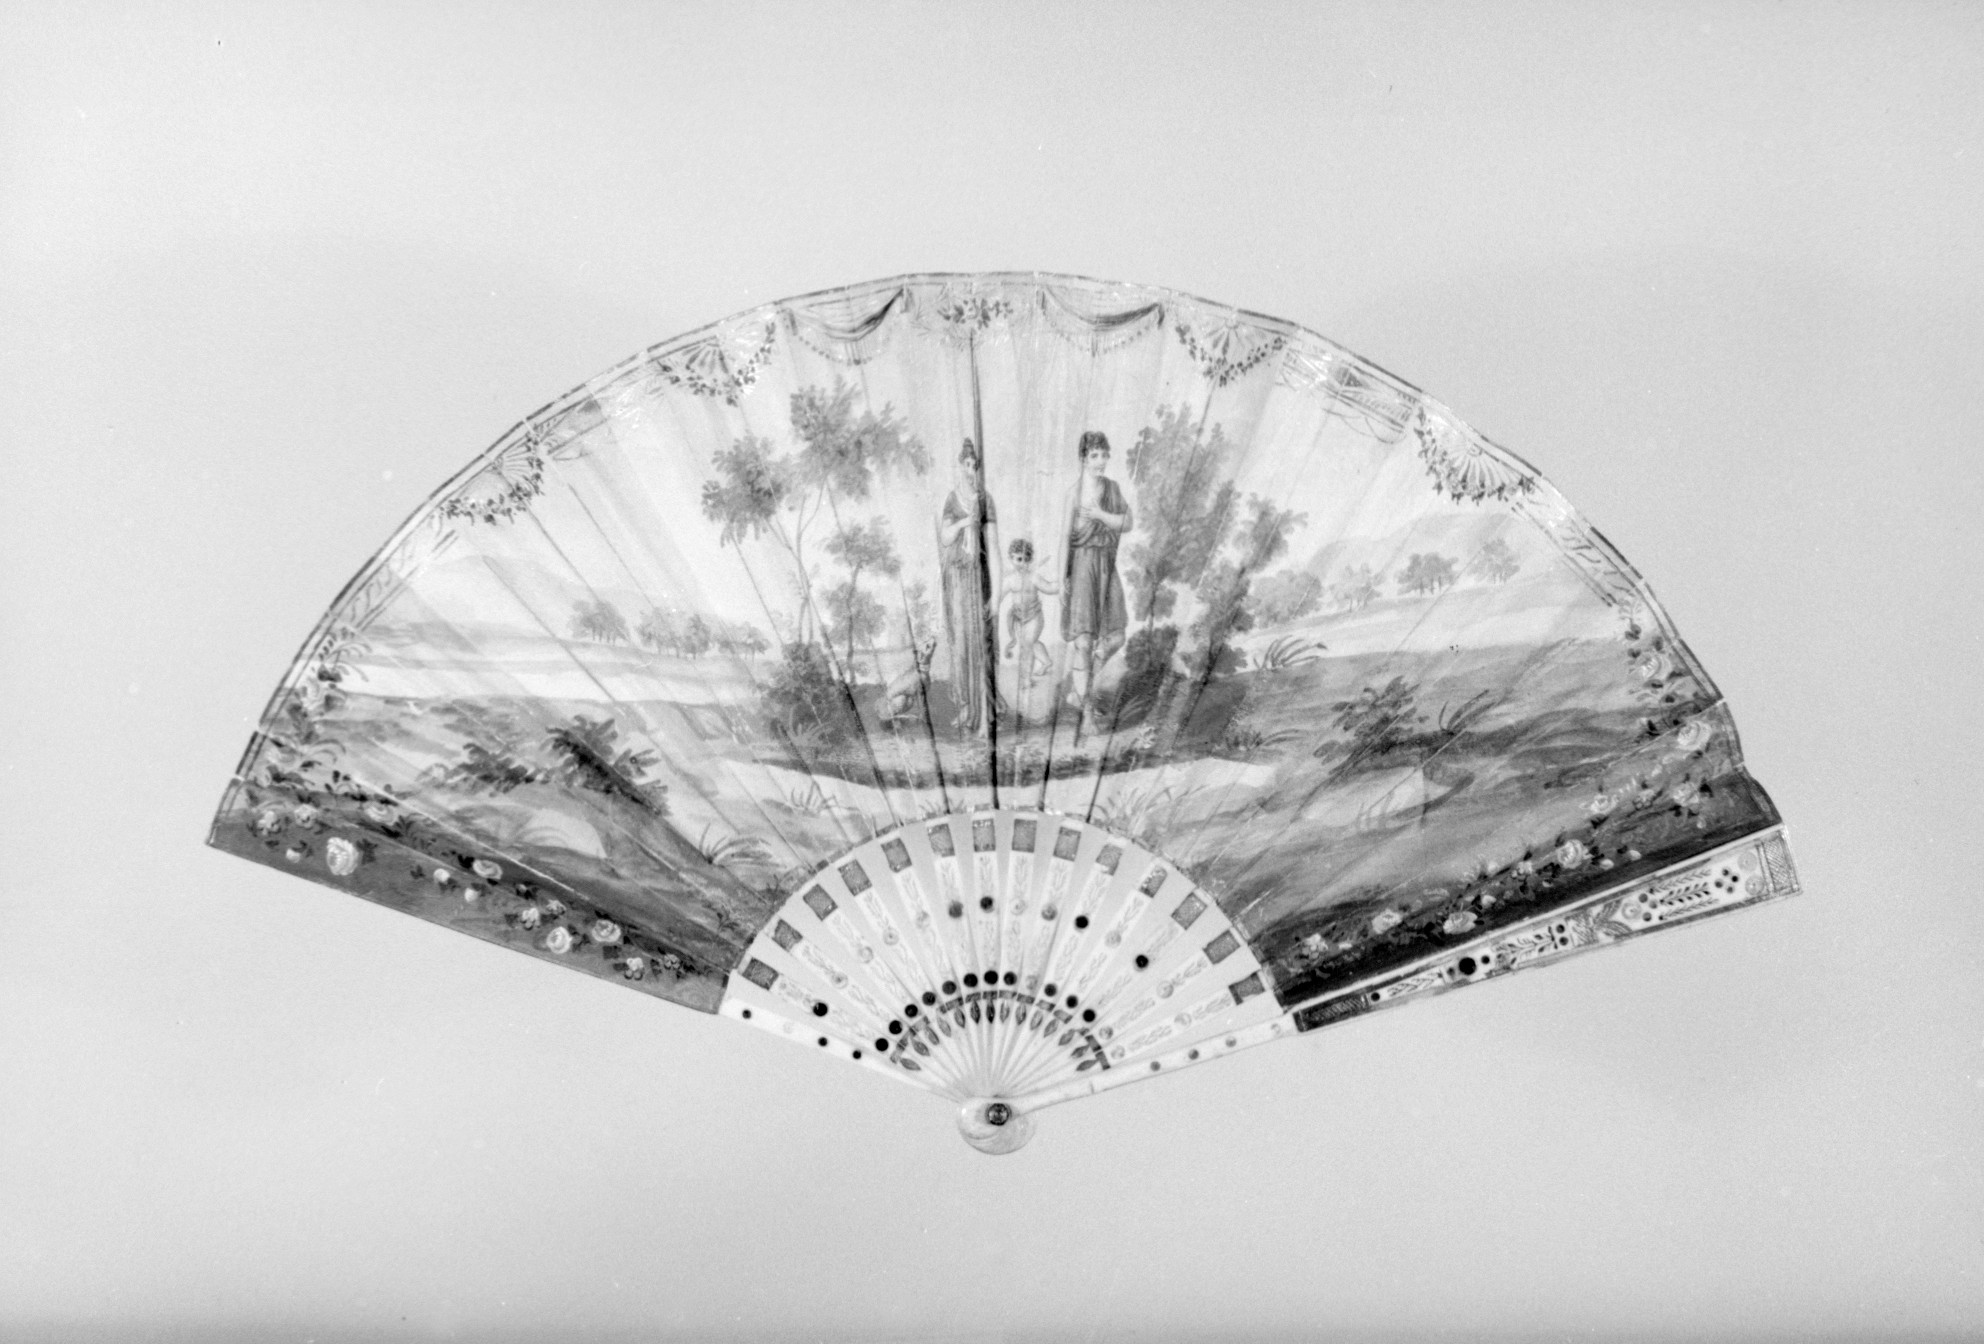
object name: fan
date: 1801-1833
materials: glass, gold, ivory, paint, paper, parchment, silver, steel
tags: men,women,cupid,dogs